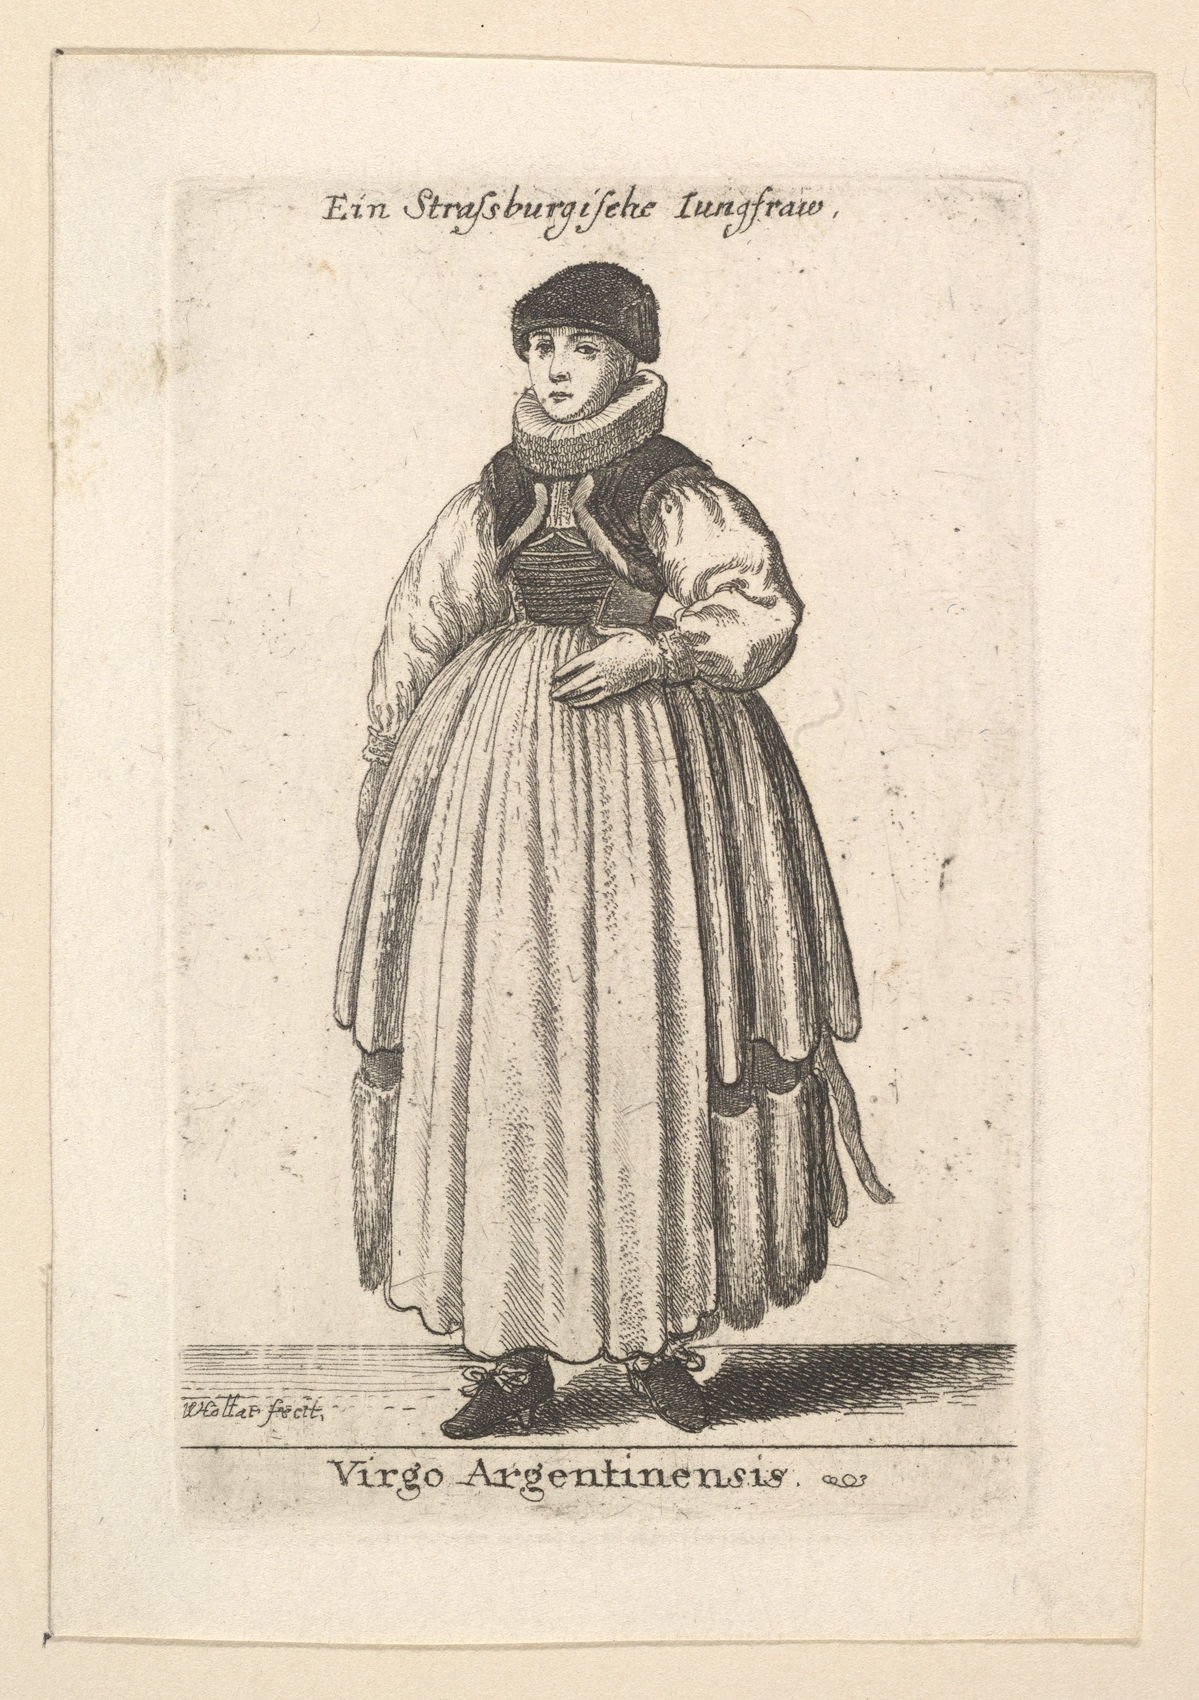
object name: print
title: Virgo Argentinensis (Unmarried woman from Strasbourg)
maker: wenceslaus hollar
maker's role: artist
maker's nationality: bohemian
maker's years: 1607-1677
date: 1644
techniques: etching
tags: women